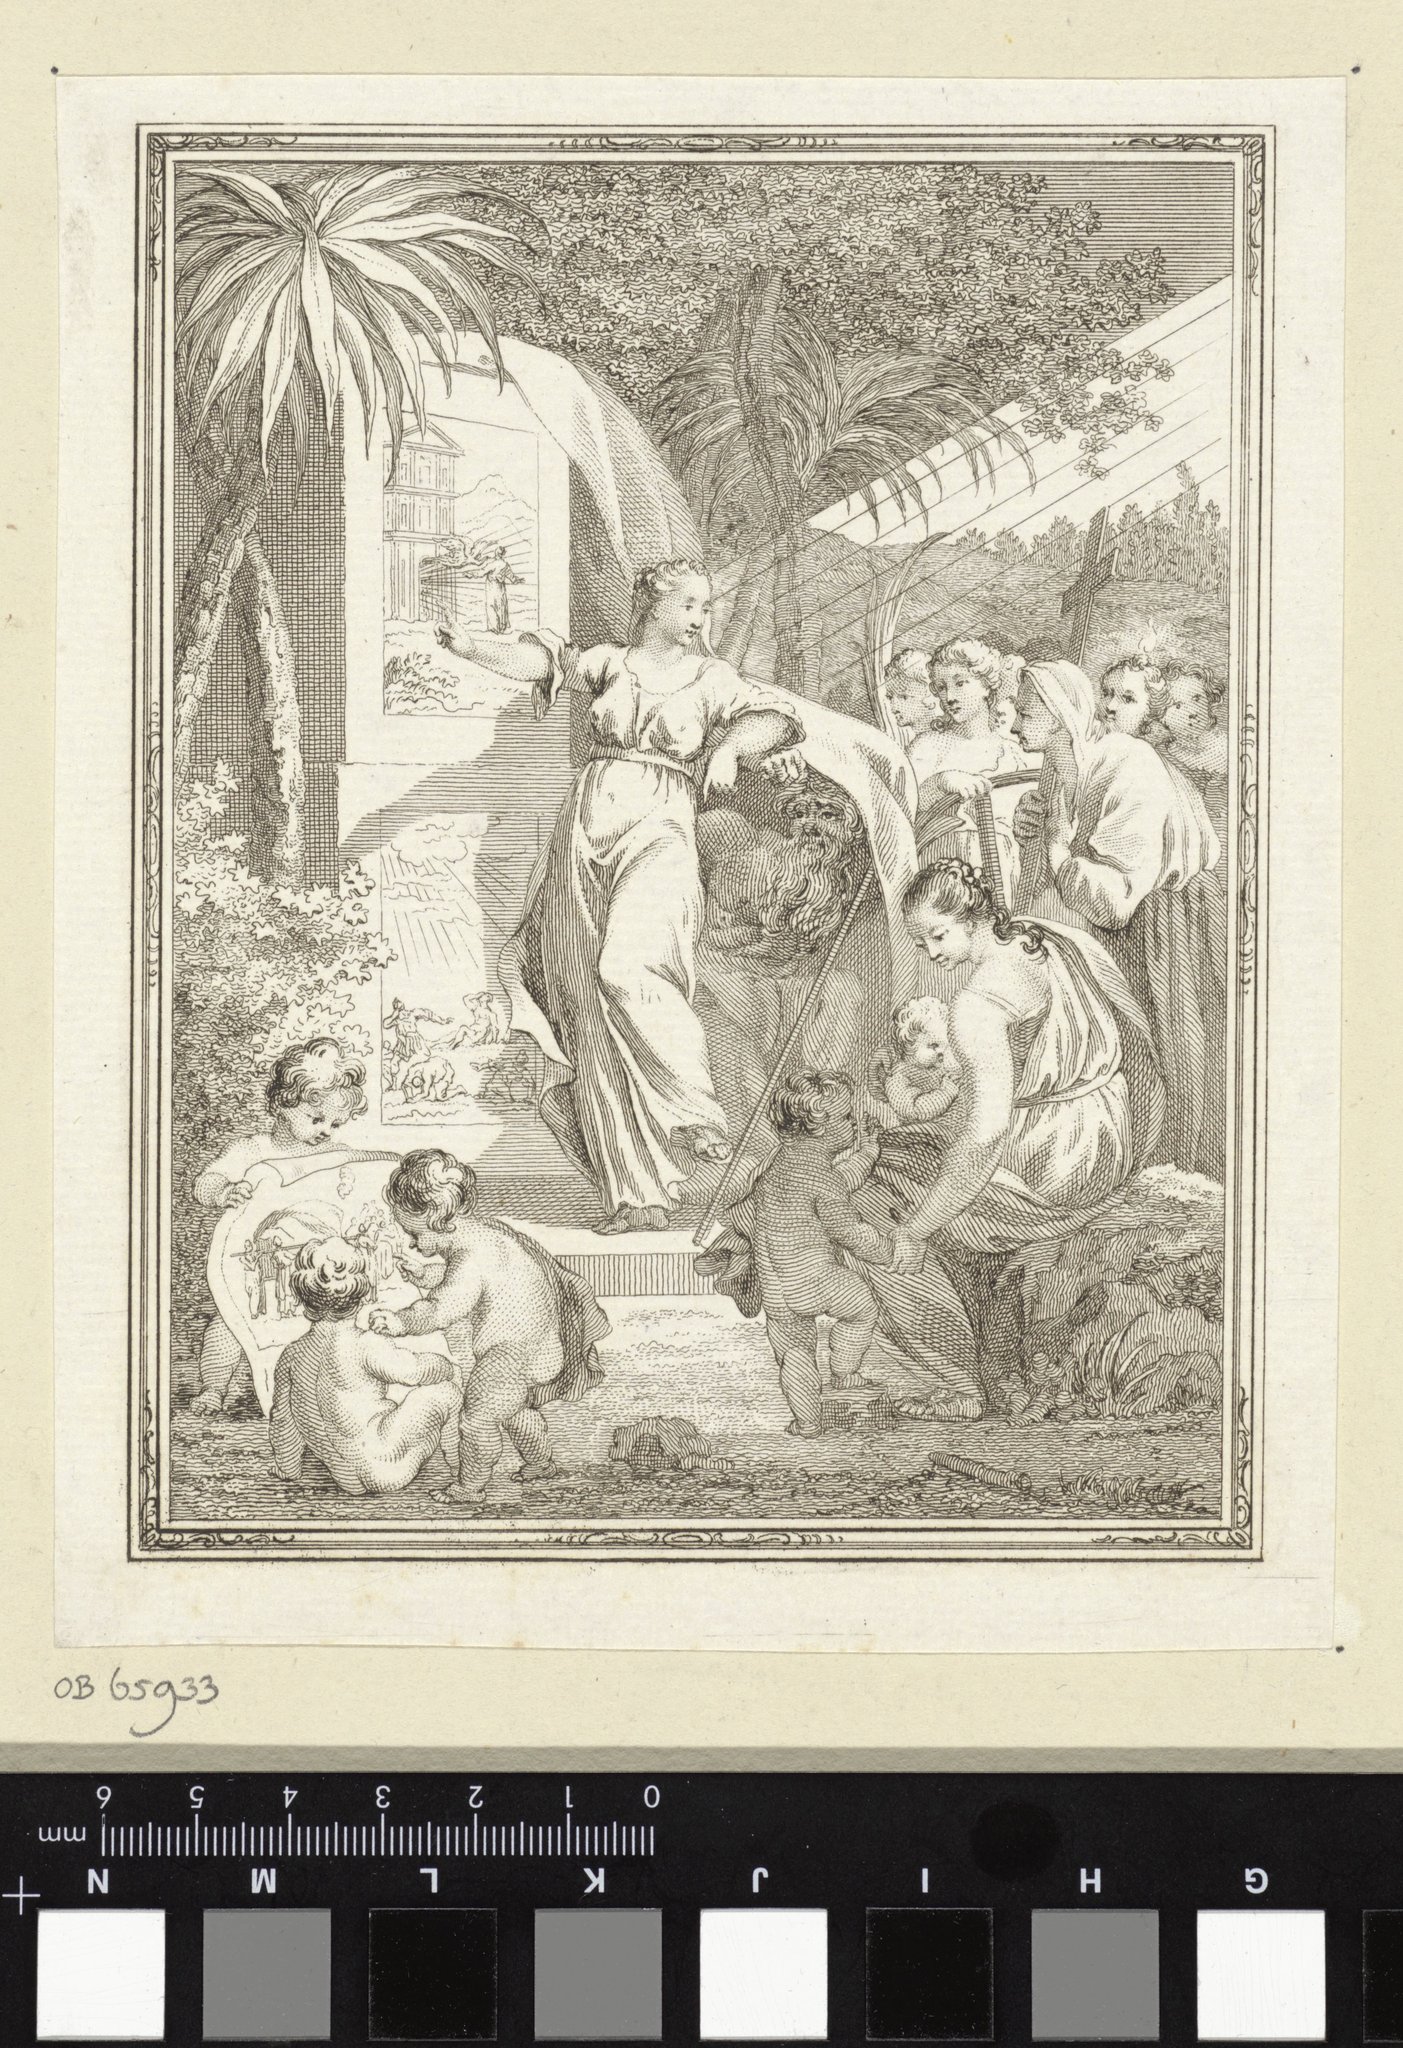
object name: print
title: Titelpagina met allegorische voorstelling van een vrouw die twee bijbelse scènes uitlegt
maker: reinier vinkeles (i)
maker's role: draughtsman, print maker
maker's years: 1741-1816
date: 1768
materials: paper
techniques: etching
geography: amsterdam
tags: fides (faith) as roman personification (+ attributes), the cross ~ symbols of christ, cupids: 'amores', 'amoretti', 'putti', address, talk, lecture (~ meeting) - aa - in the open air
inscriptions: collector's mark: Lugt 240